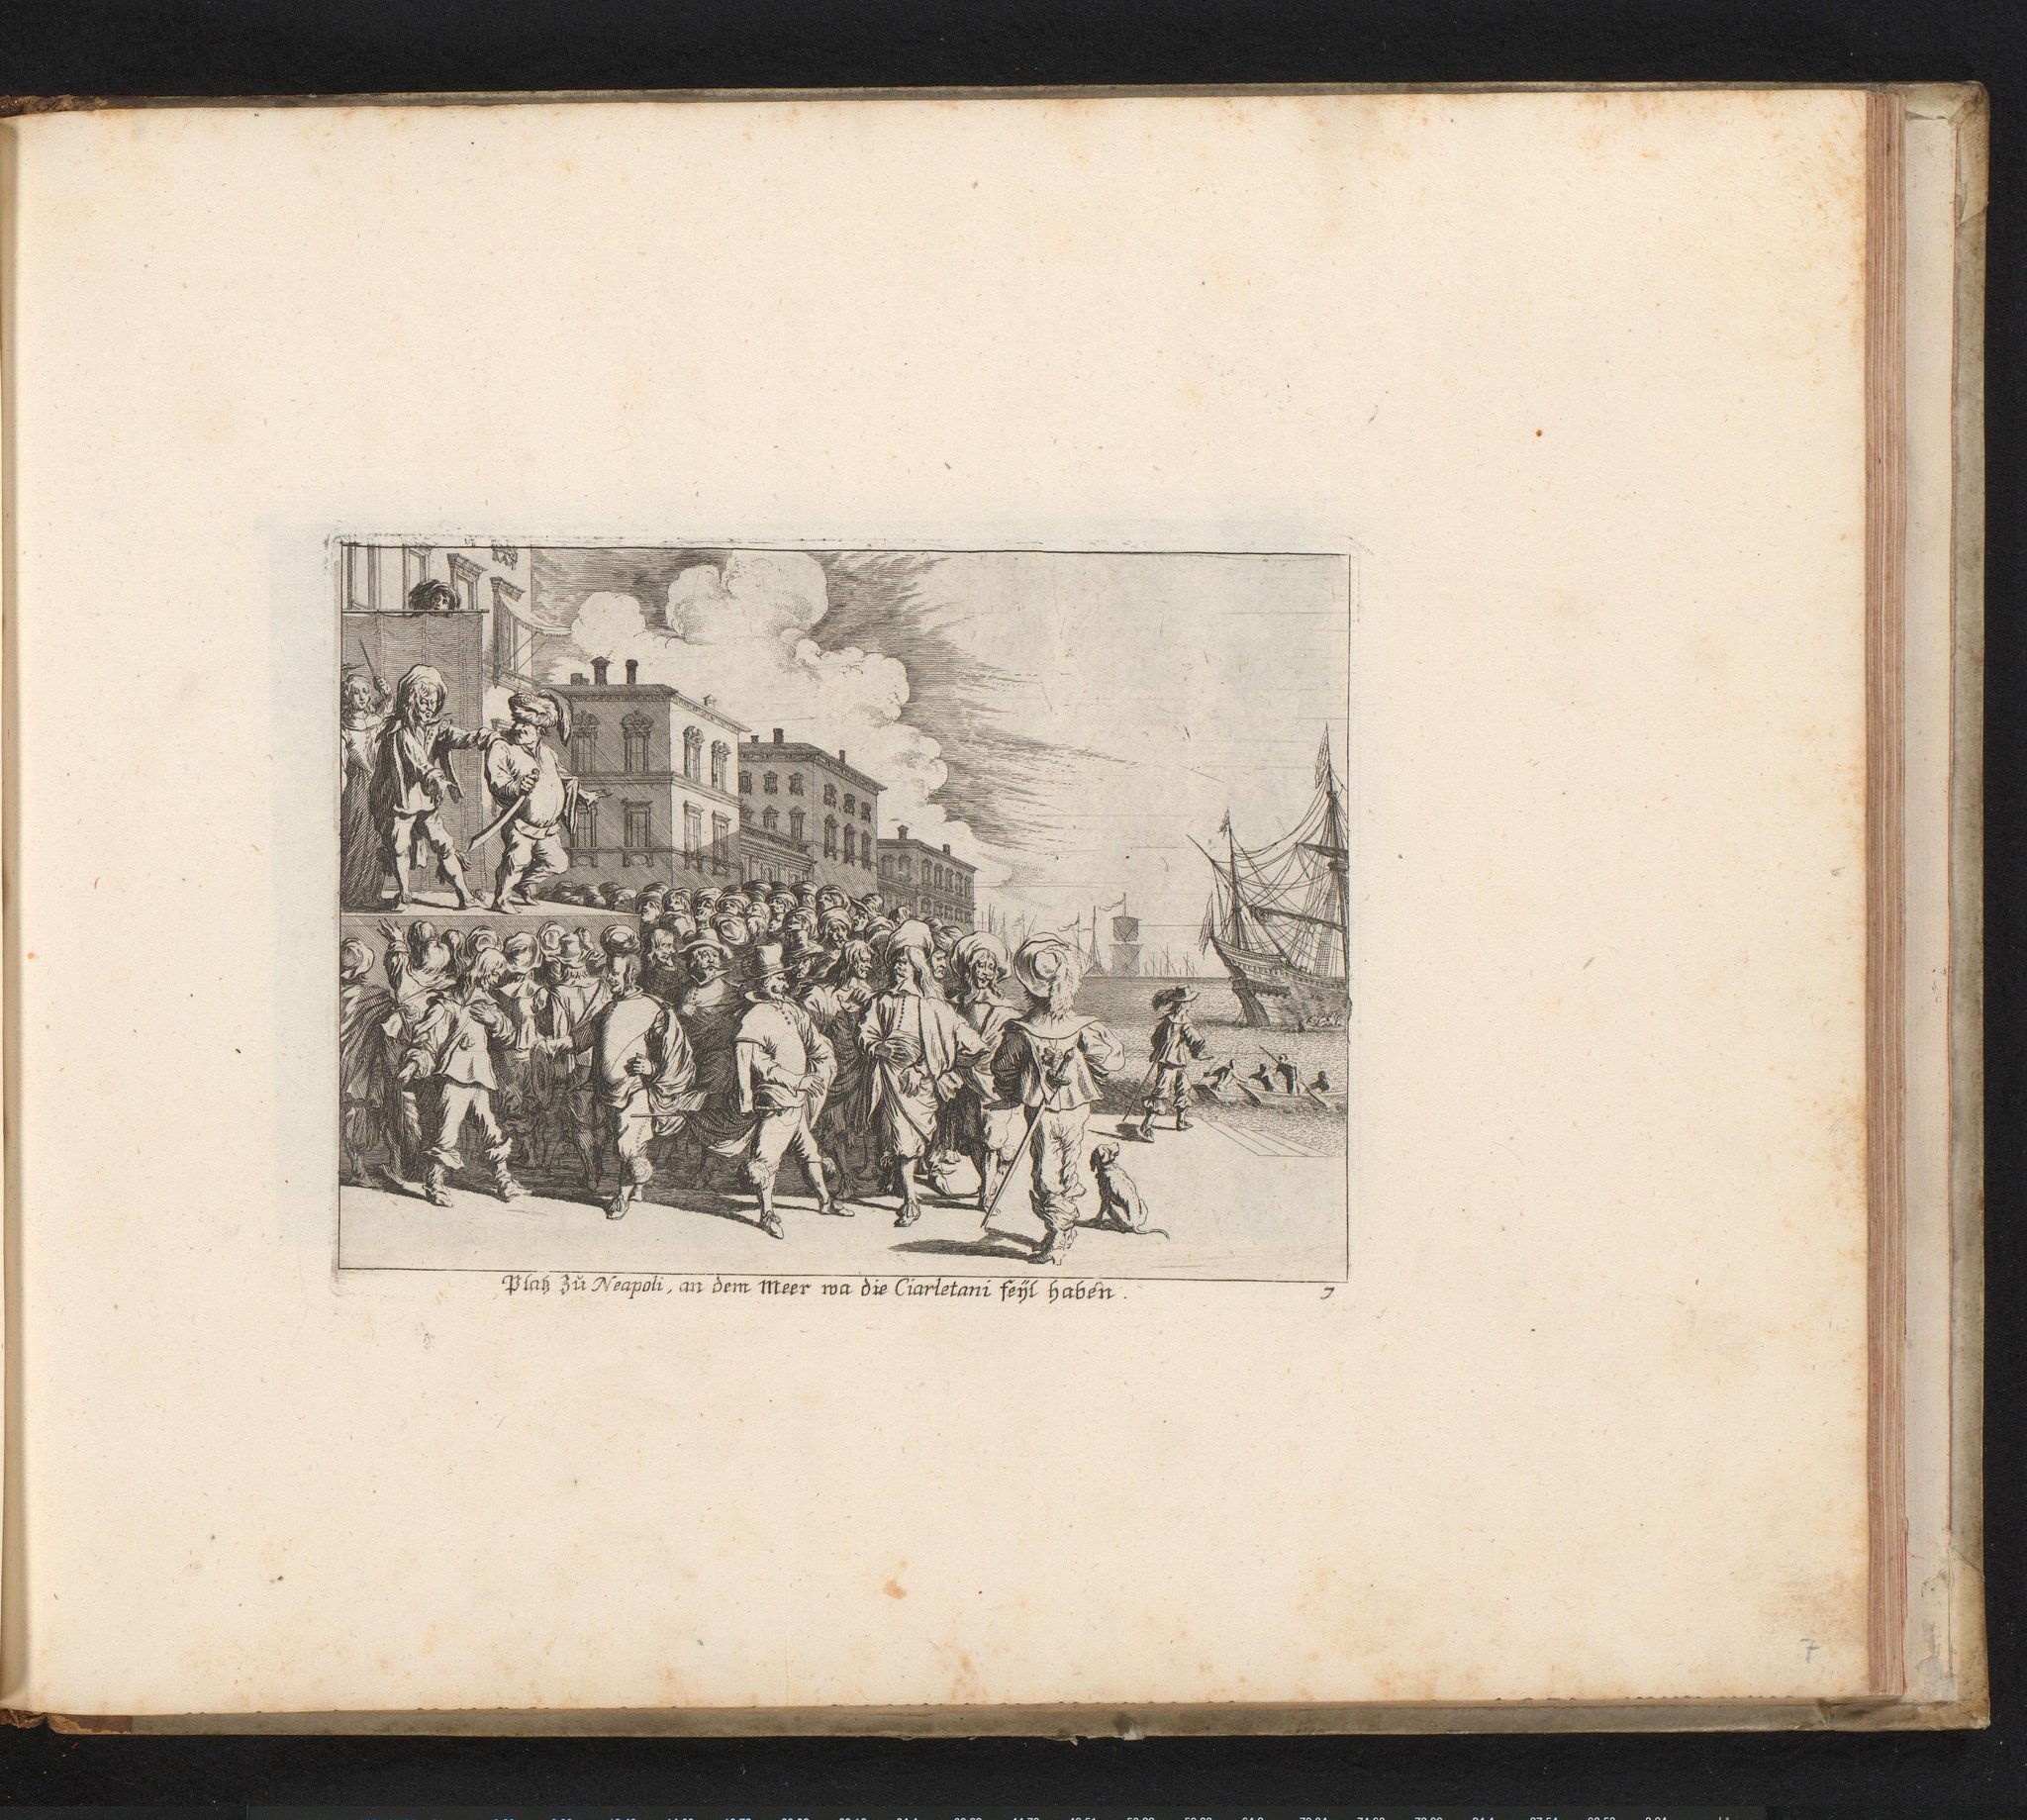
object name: print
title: Opvoering in de haven van Napels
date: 1670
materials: paper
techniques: etching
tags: performance, pier, quay, wharf, naples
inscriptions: collector's mark: Lugt 2228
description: Tekst in het Duits in de ondermarge. Rechtsonder genummerd: 7. Prent maakt deel uit van een album.